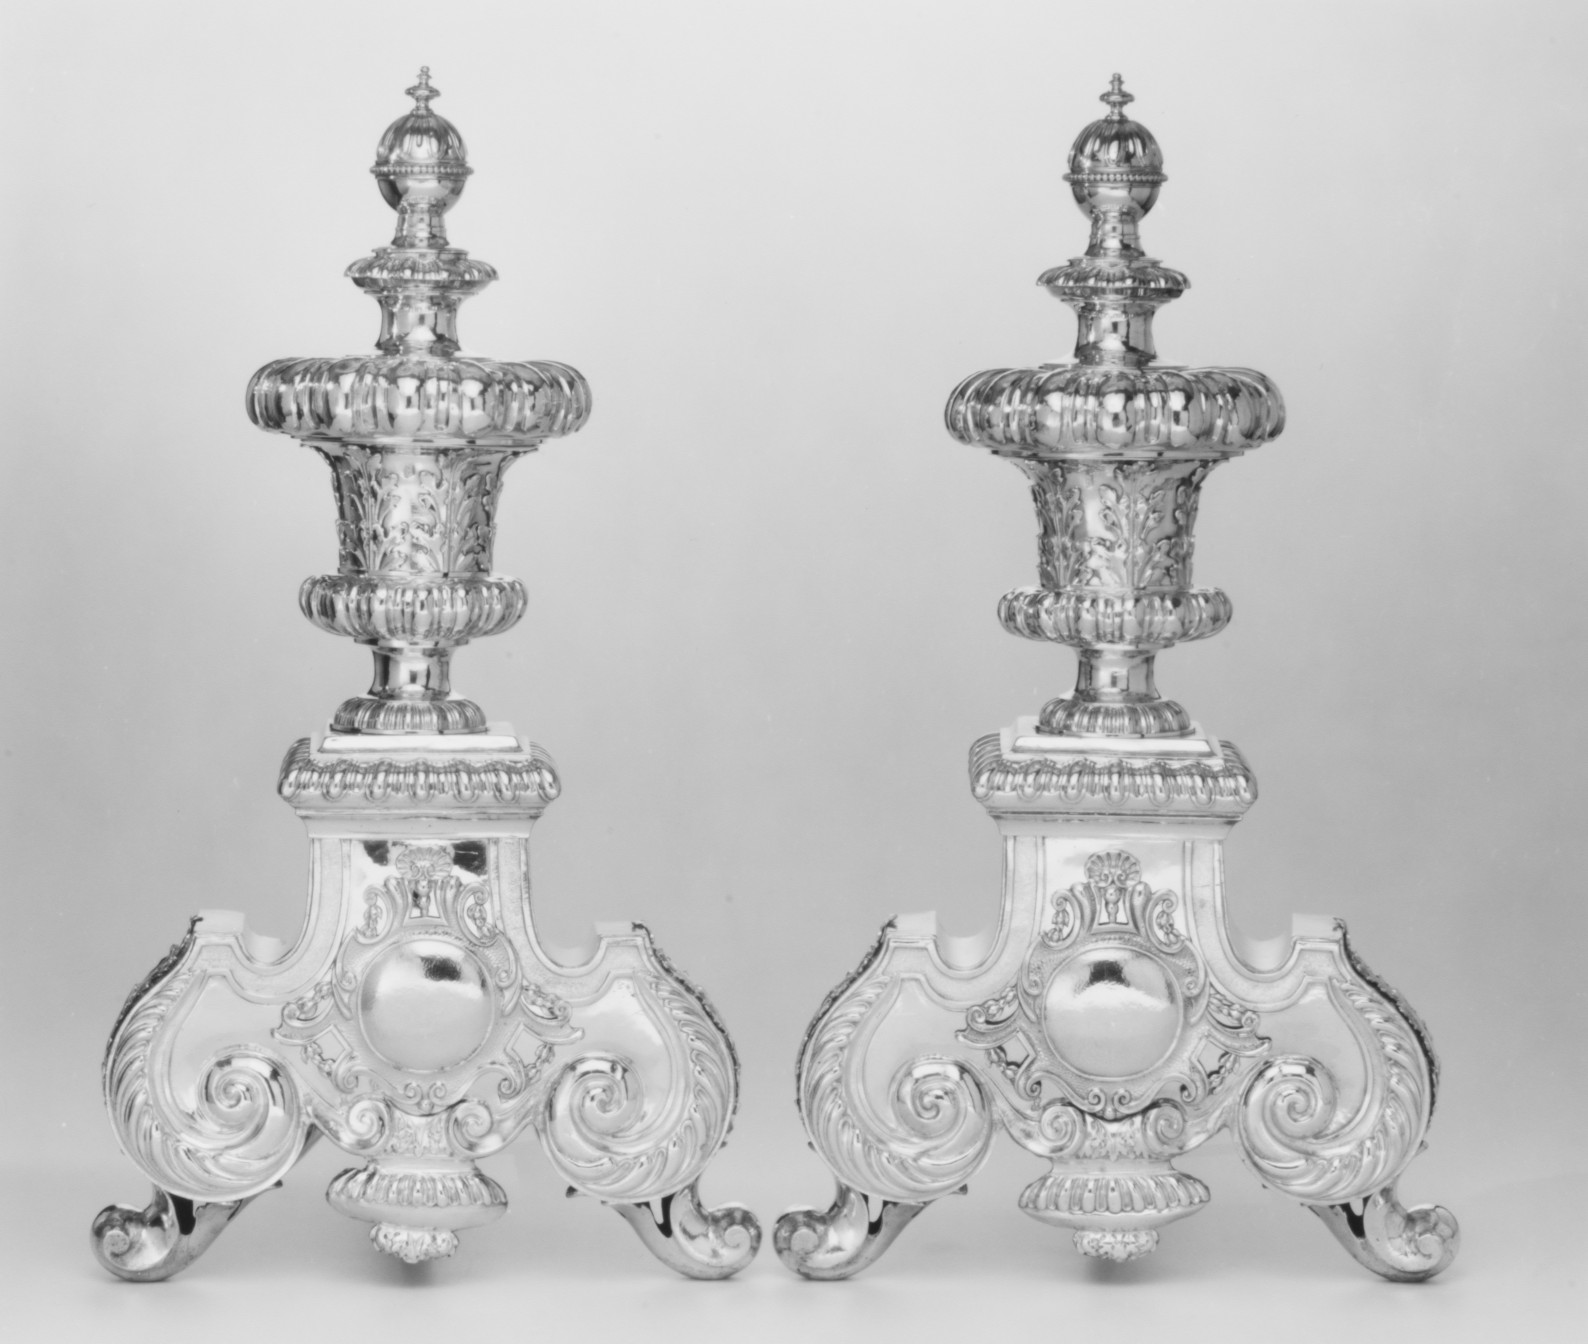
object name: andiron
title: Pair of andirons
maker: benjamin pyne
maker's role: maker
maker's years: 1693-1727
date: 1697-1698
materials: iron, silver